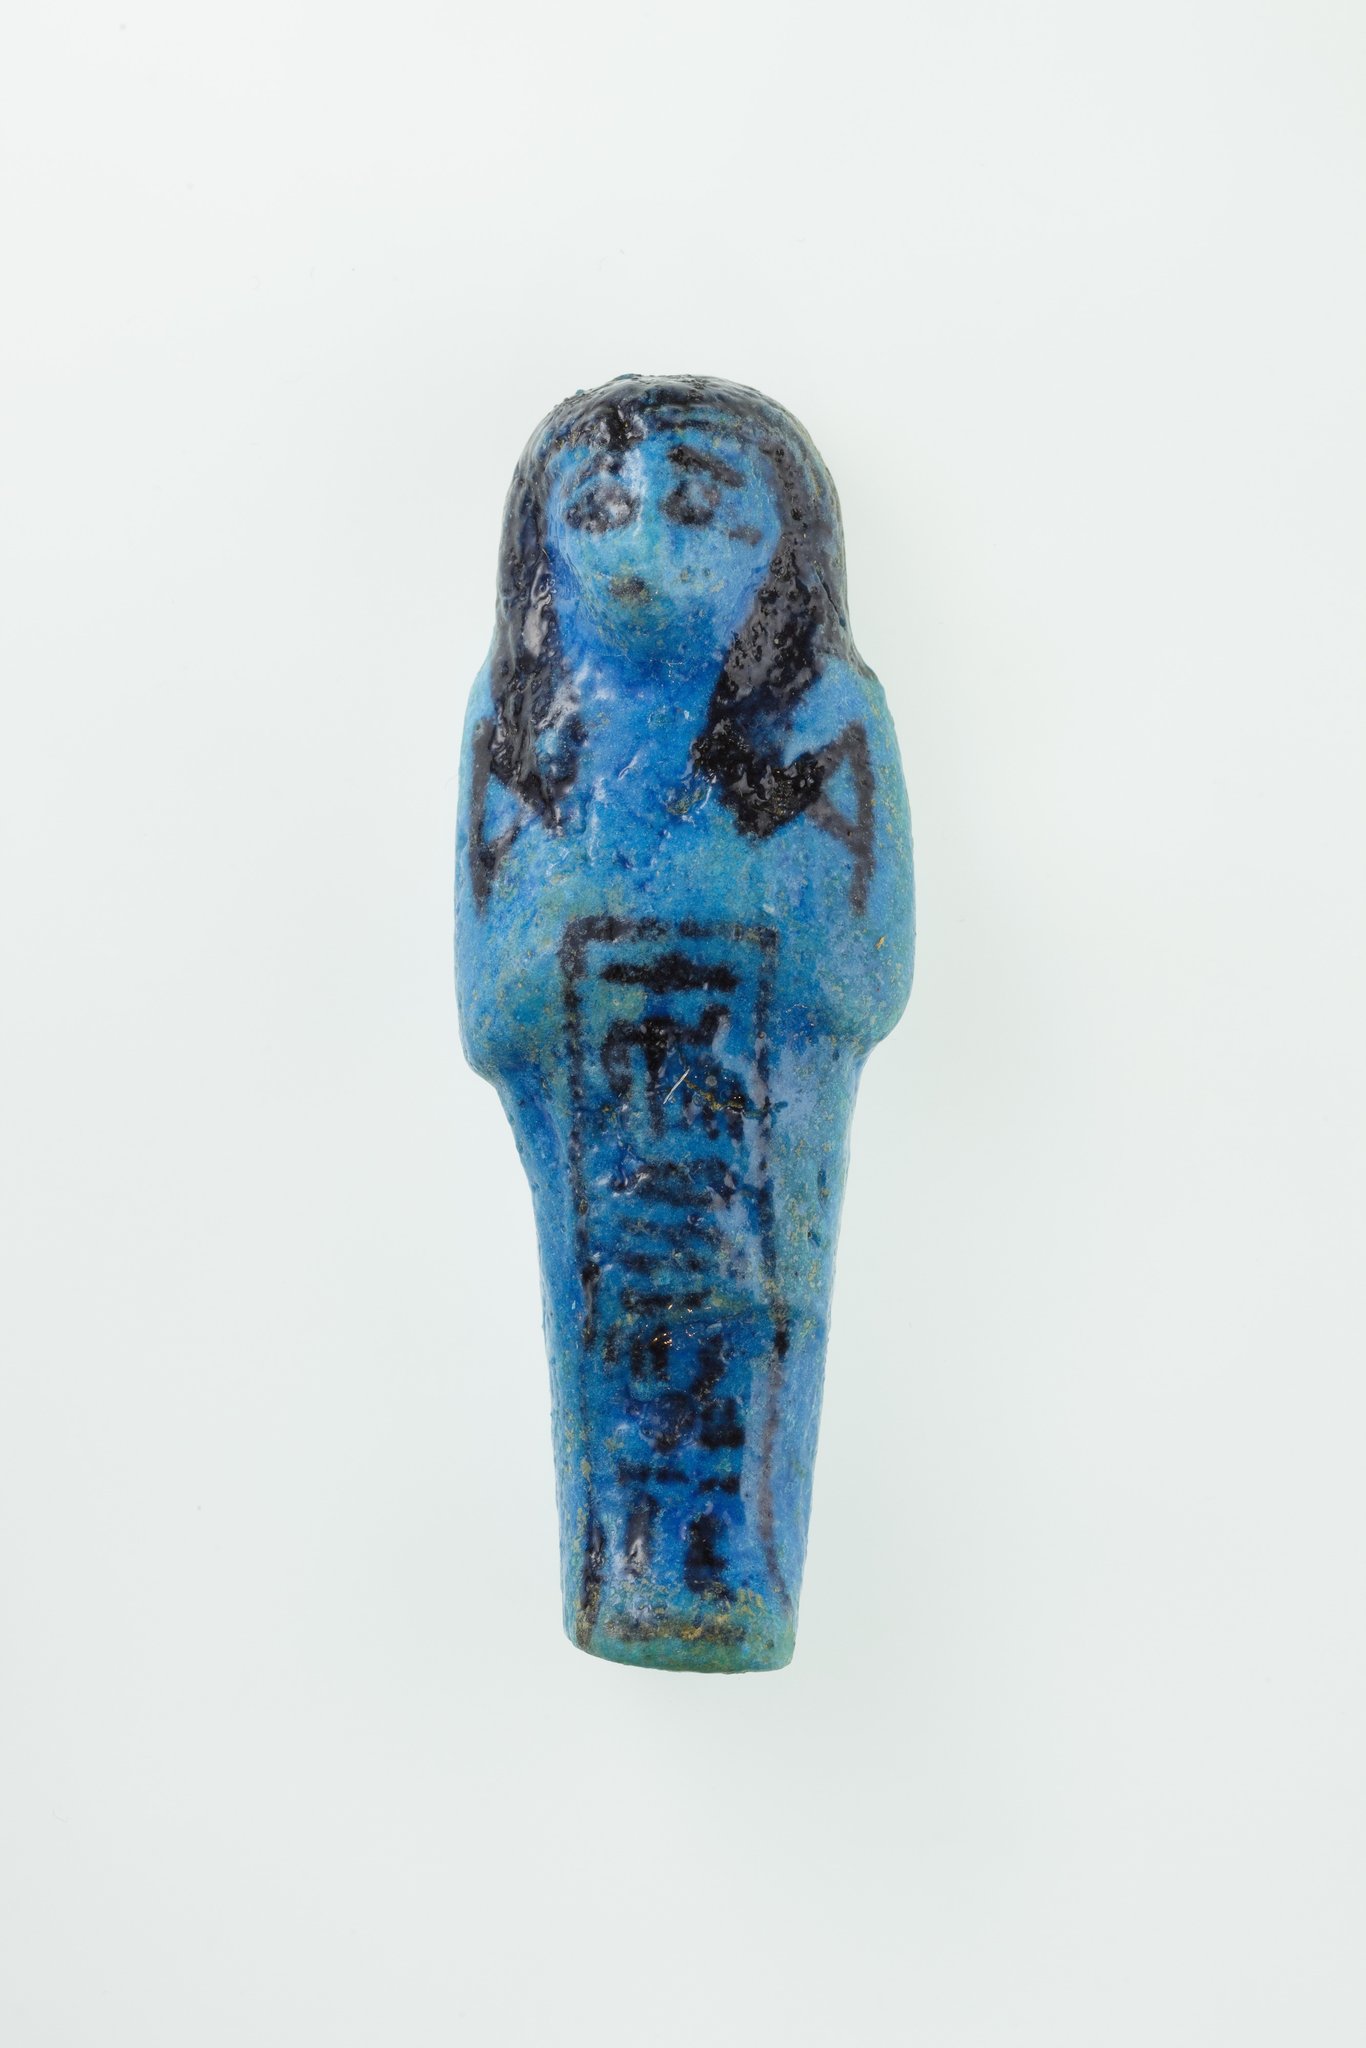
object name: shabti, worker, nauny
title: Worker Shabti of Nauny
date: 1050 BCE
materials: faience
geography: egypt